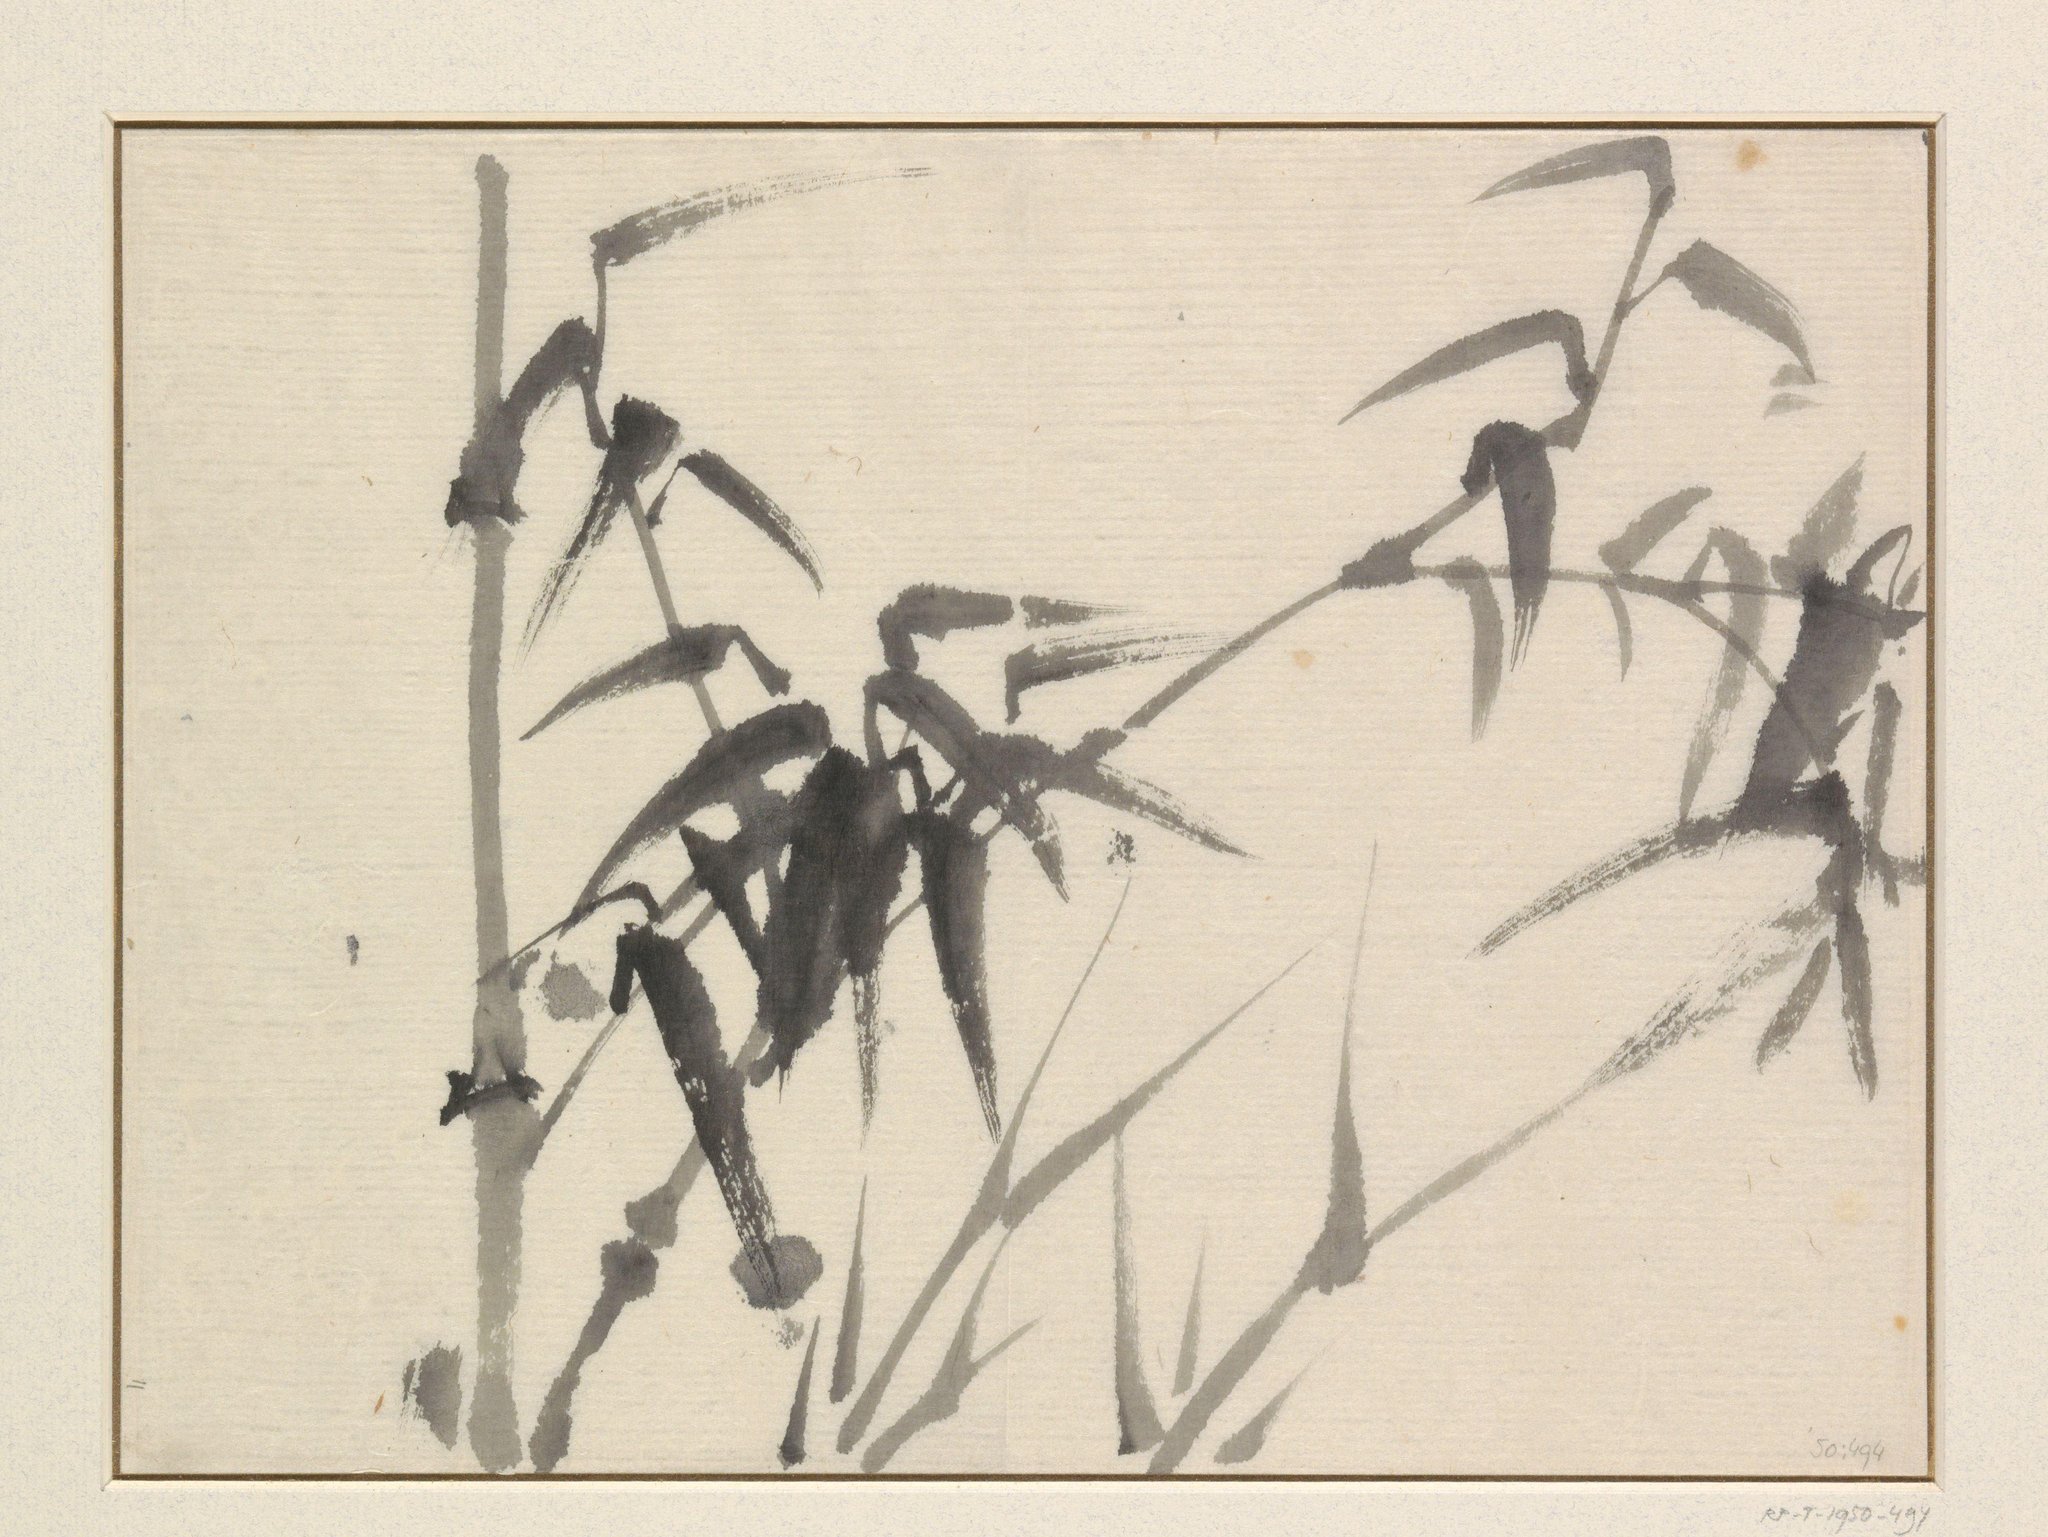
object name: drawing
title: Bamboestengels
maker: ichirakasai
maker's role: draughtsman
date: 1700-1900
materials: paper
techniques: brush